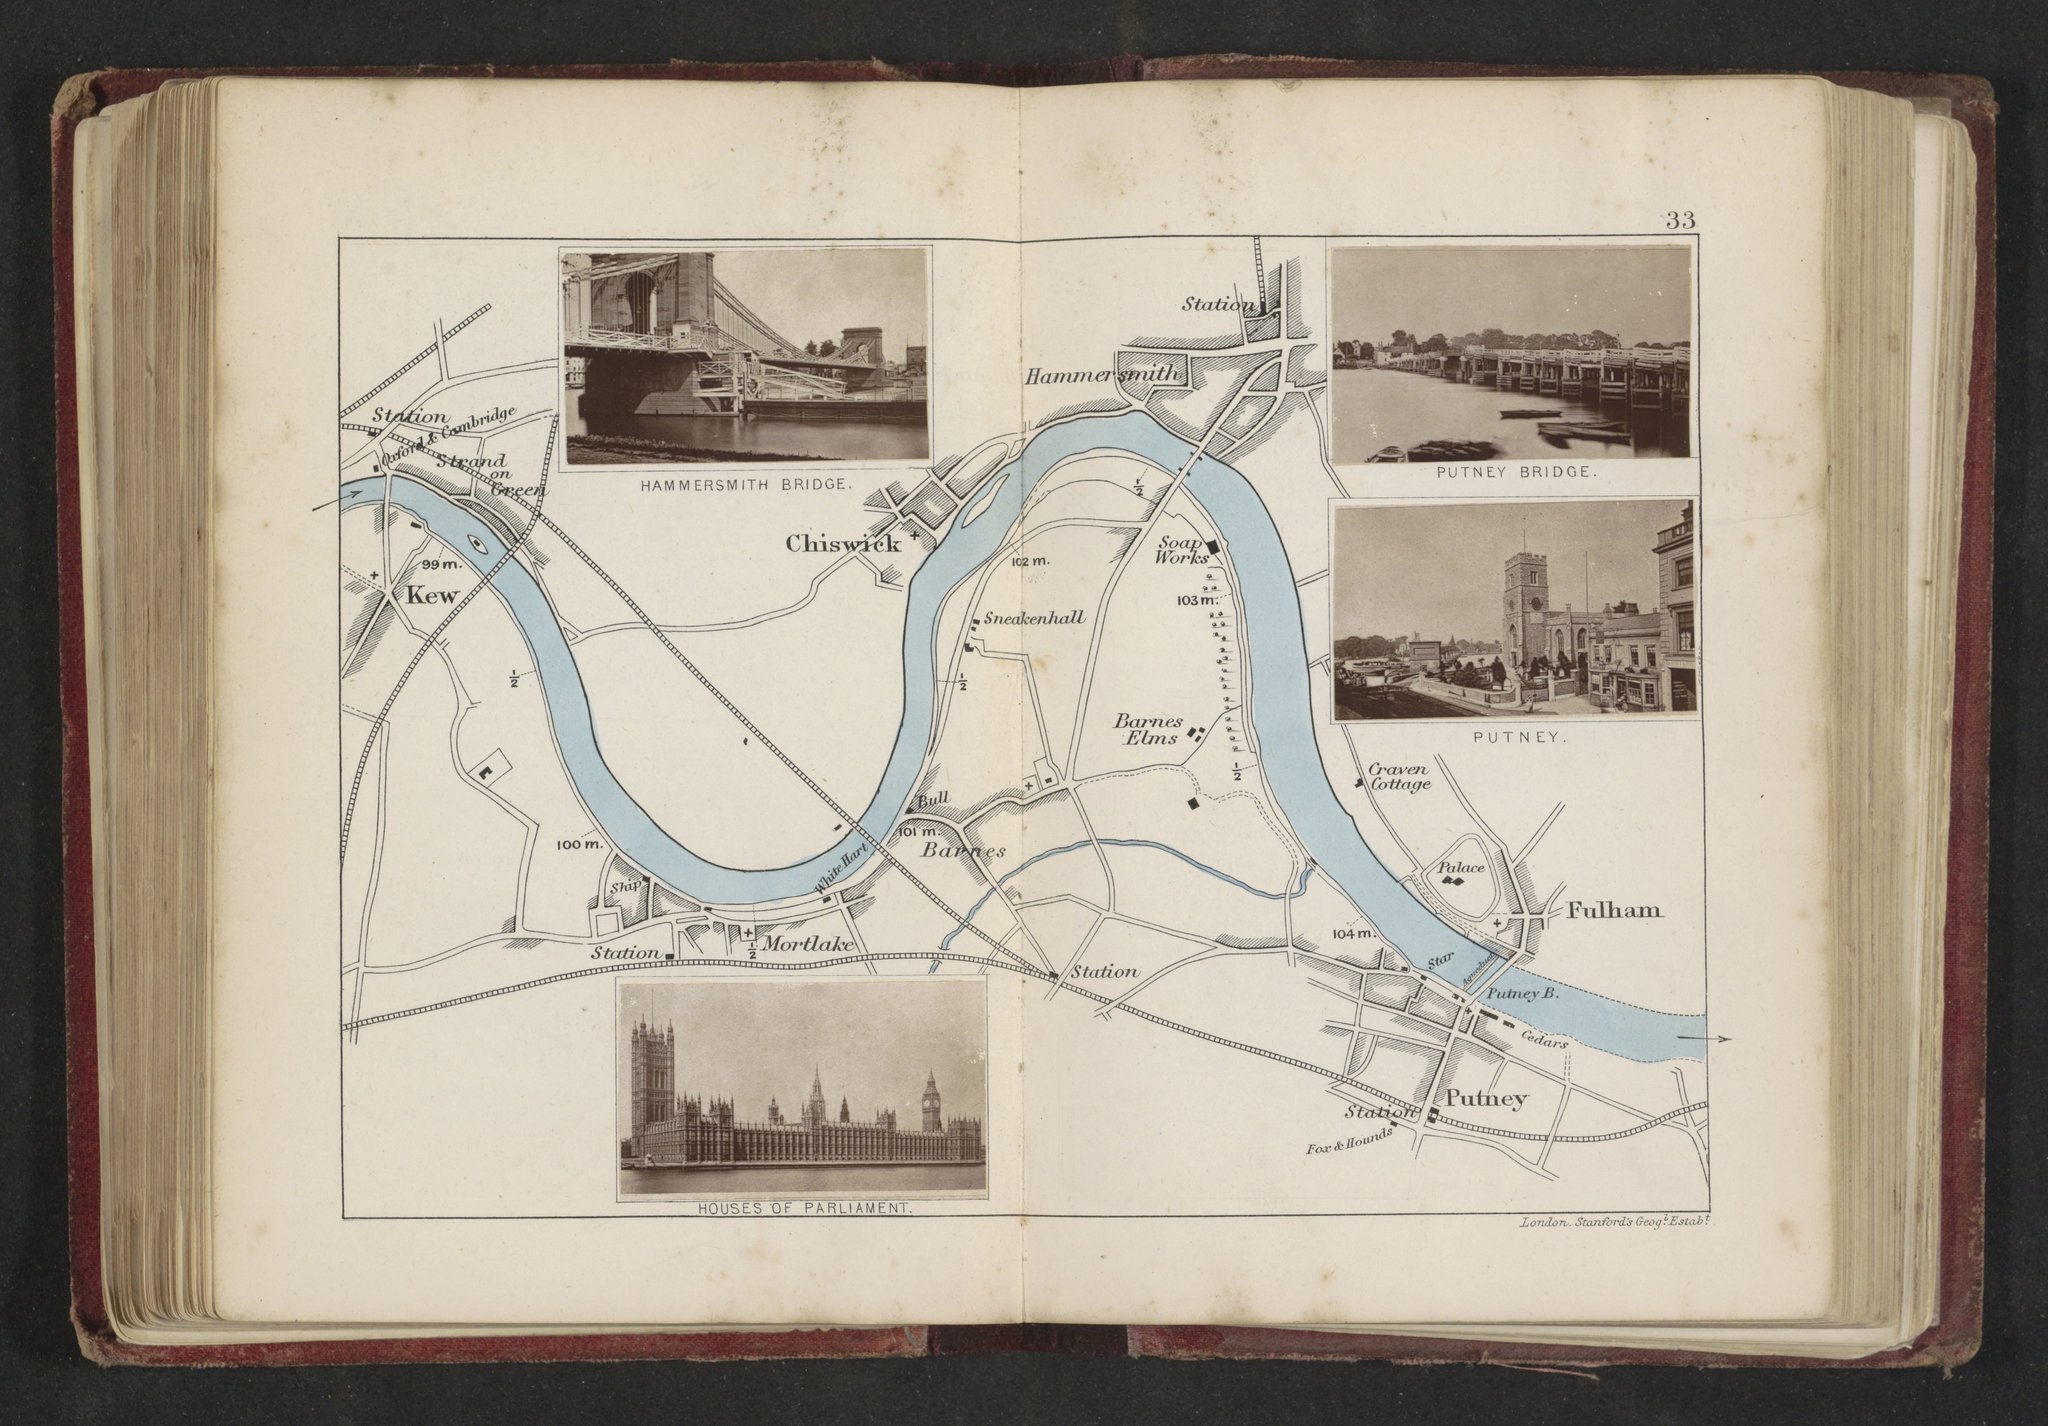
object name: page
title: Kaart met drie afbeeldingen van plaatsen langs de Theems in Londen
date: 1878-1879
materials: paper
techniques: engraving, woodburytype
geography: london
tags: river, bridge in city across river, canal, etc., lower house, parliament, chamber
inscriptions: name: ‘London. Stanford's Geogl. Estabt.’, inscription: ‘Hammersmith bridge. Houses of Parliament. Putney bridge. Putney’, number: ‘33’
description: Links: gezicht op Hammersmith Bridge en de Houses of Parliament, rechts: gezicht op een brug en de wijk Putney.